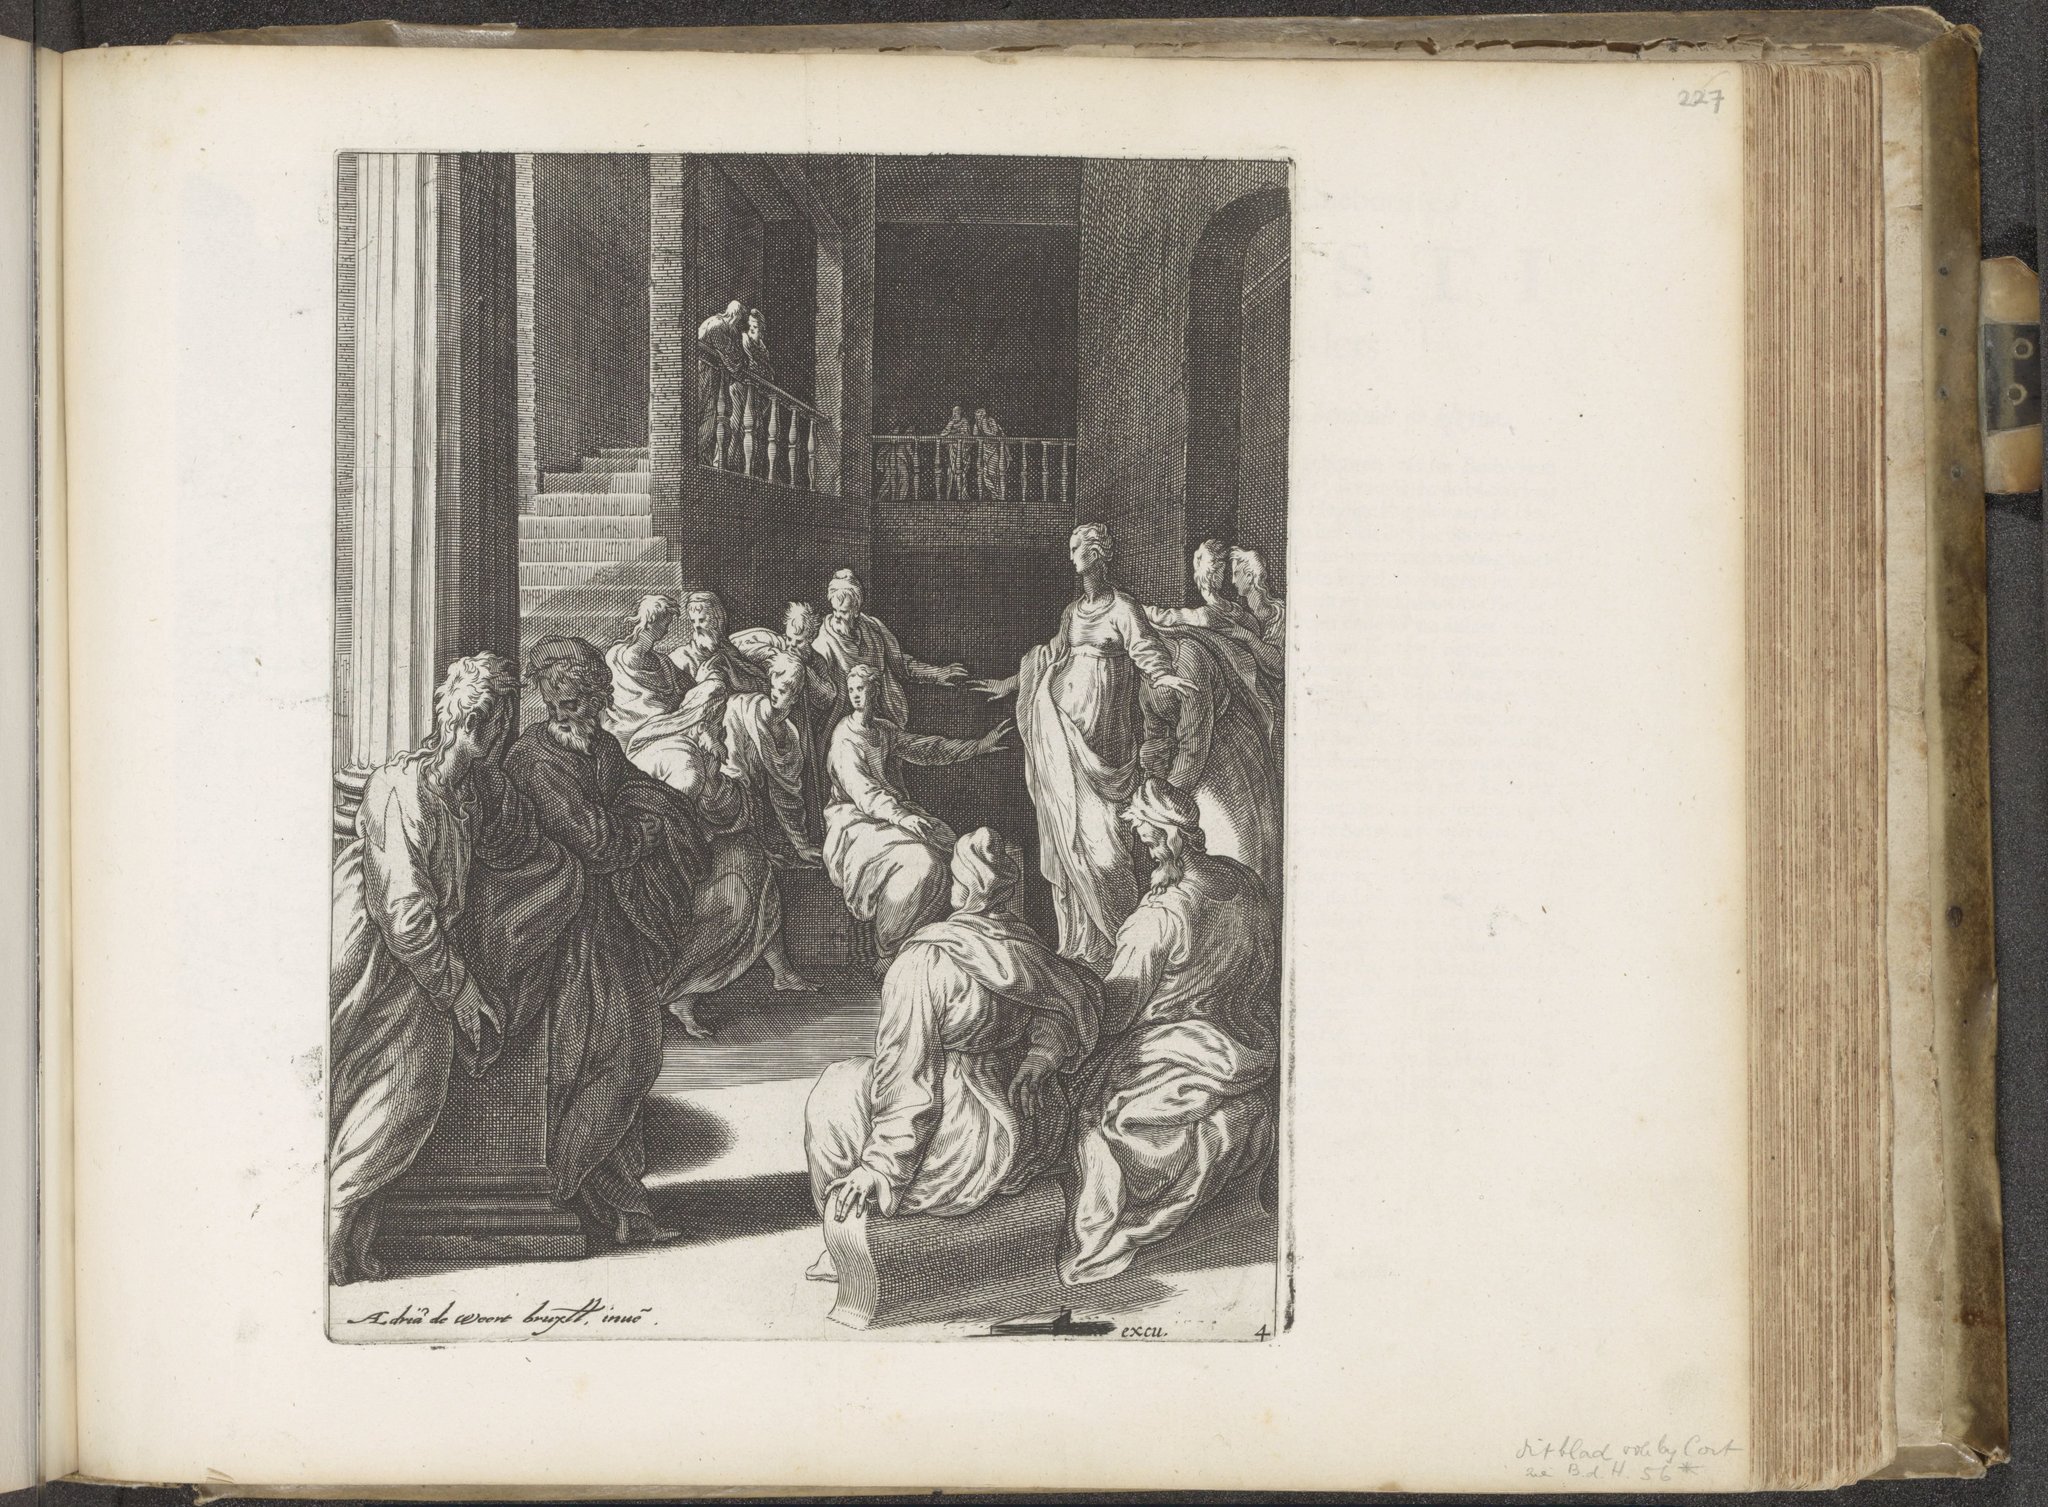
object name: album leaf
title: Leven van Christus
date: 1653-1654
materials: paper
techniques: engraving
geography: amsterdam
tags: christ's dispute with the doctors in the temple; he counts his arguments on his fingers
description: Christus discussieert met de schriftgeleerden in de tempel. De prent maakt deel uit van een album.